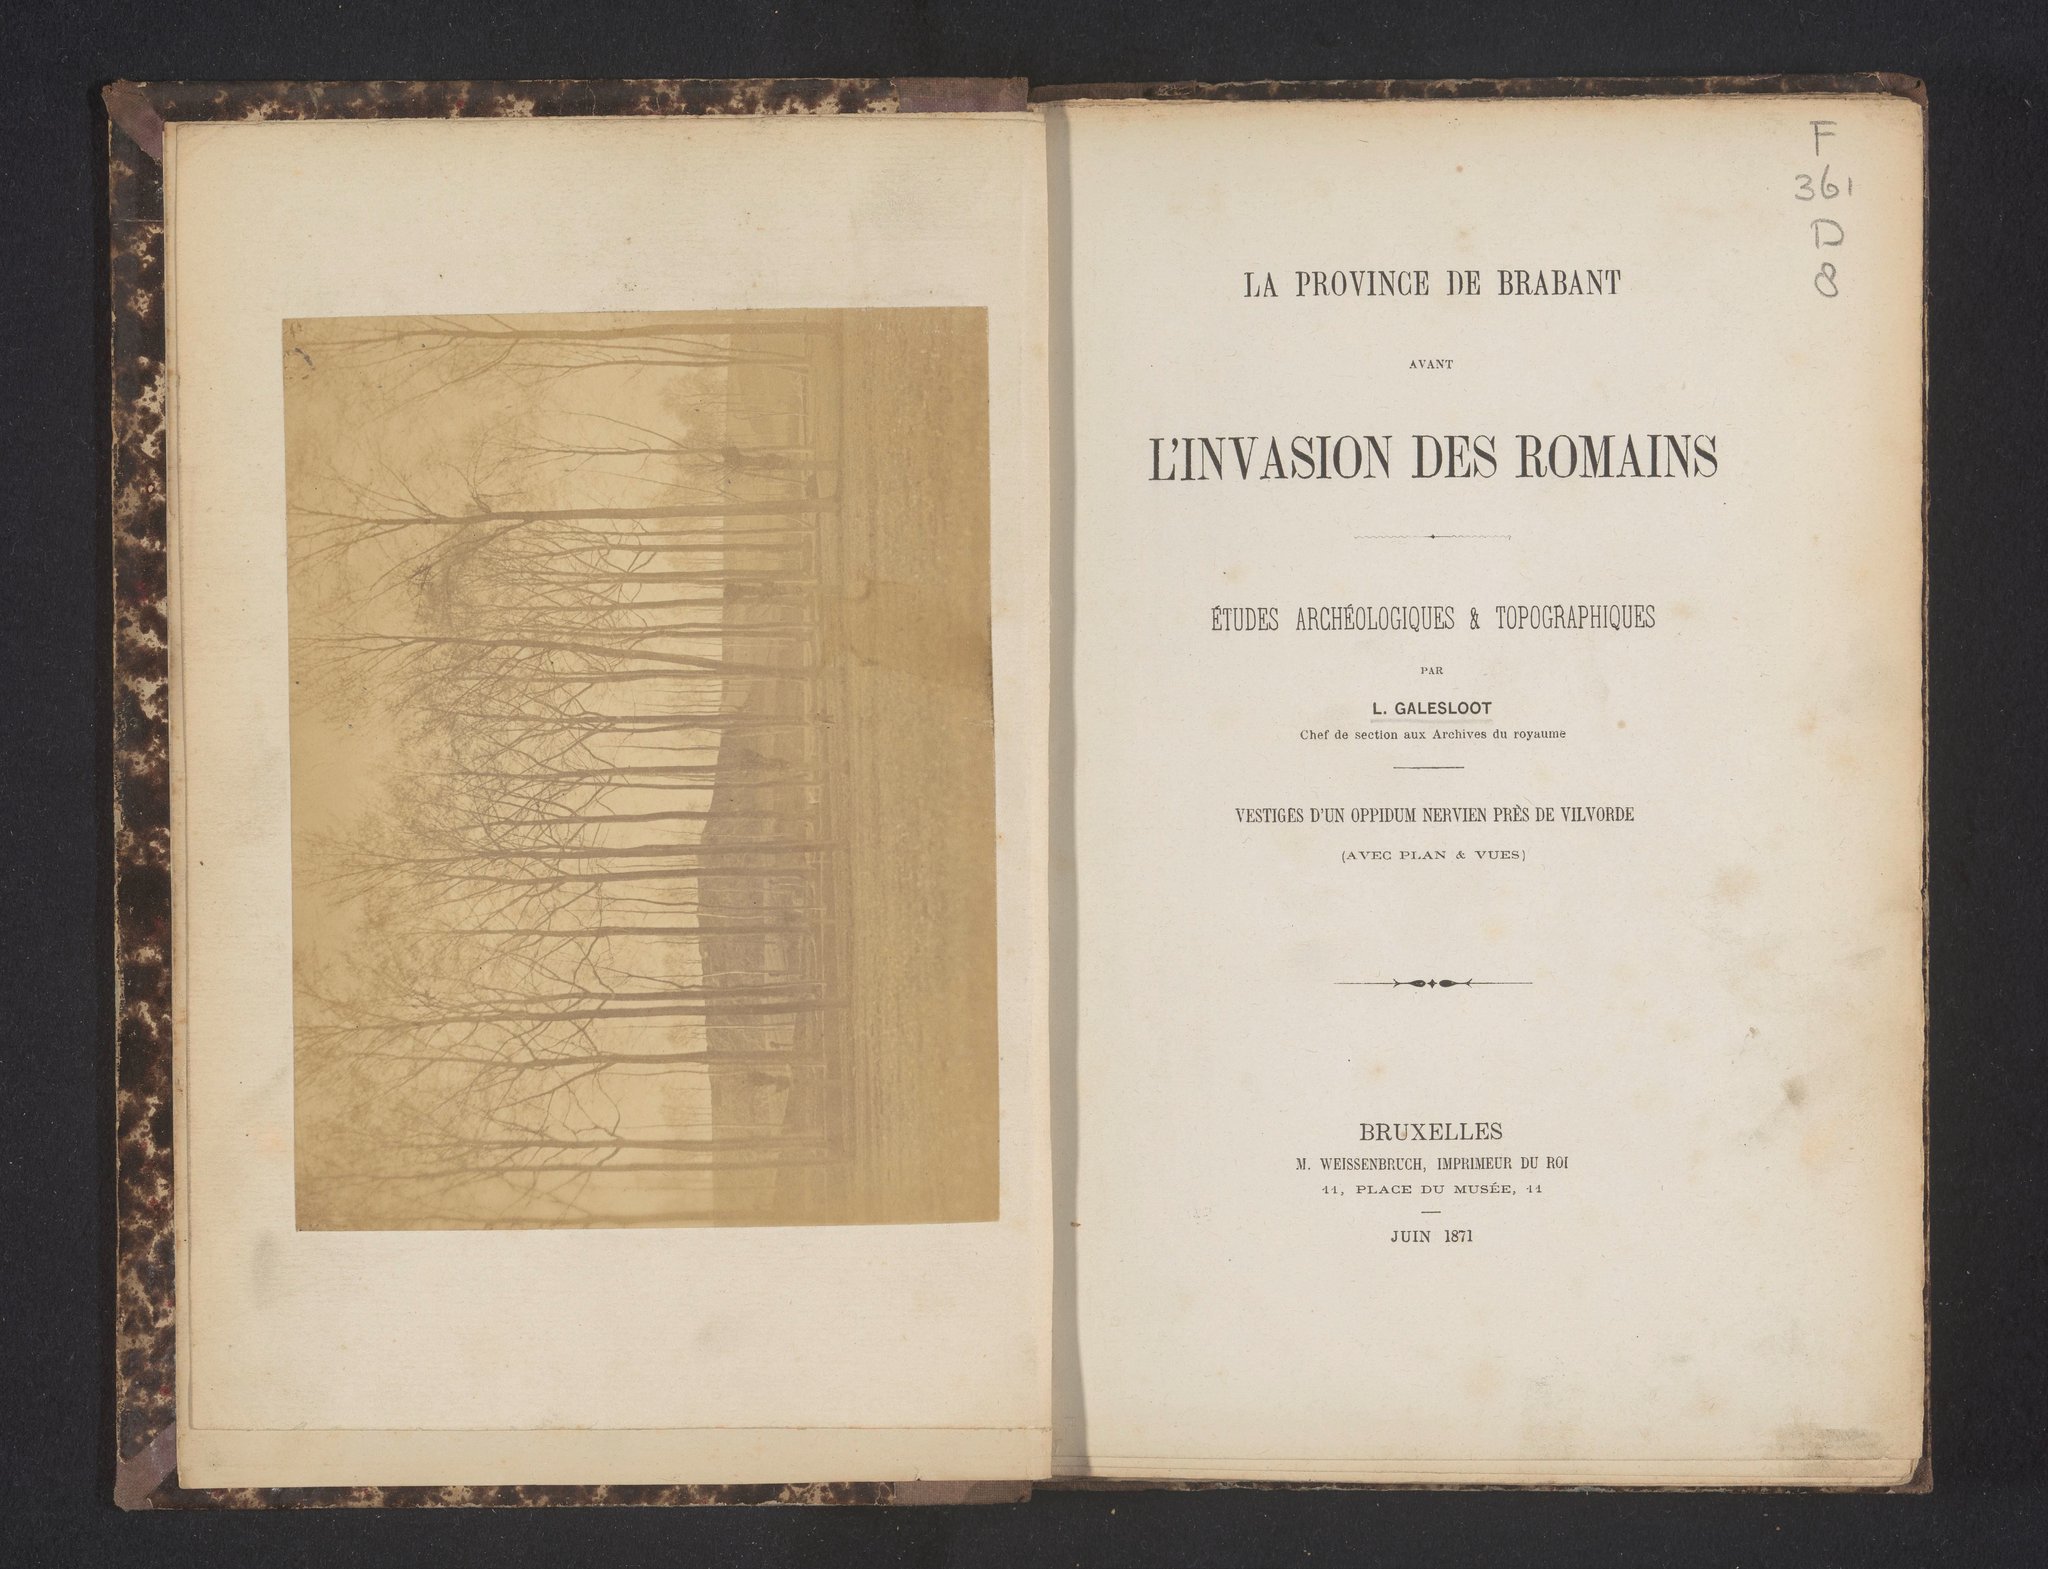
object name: book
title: La province de Brabant avant l'invasion des romains : études archéologiques et topographiques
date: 1871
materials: linen, paper, photographic support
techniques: albumen print, printing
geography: brussels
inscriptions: annotation: ‘50 €’, date: ‘JUNE 2003’